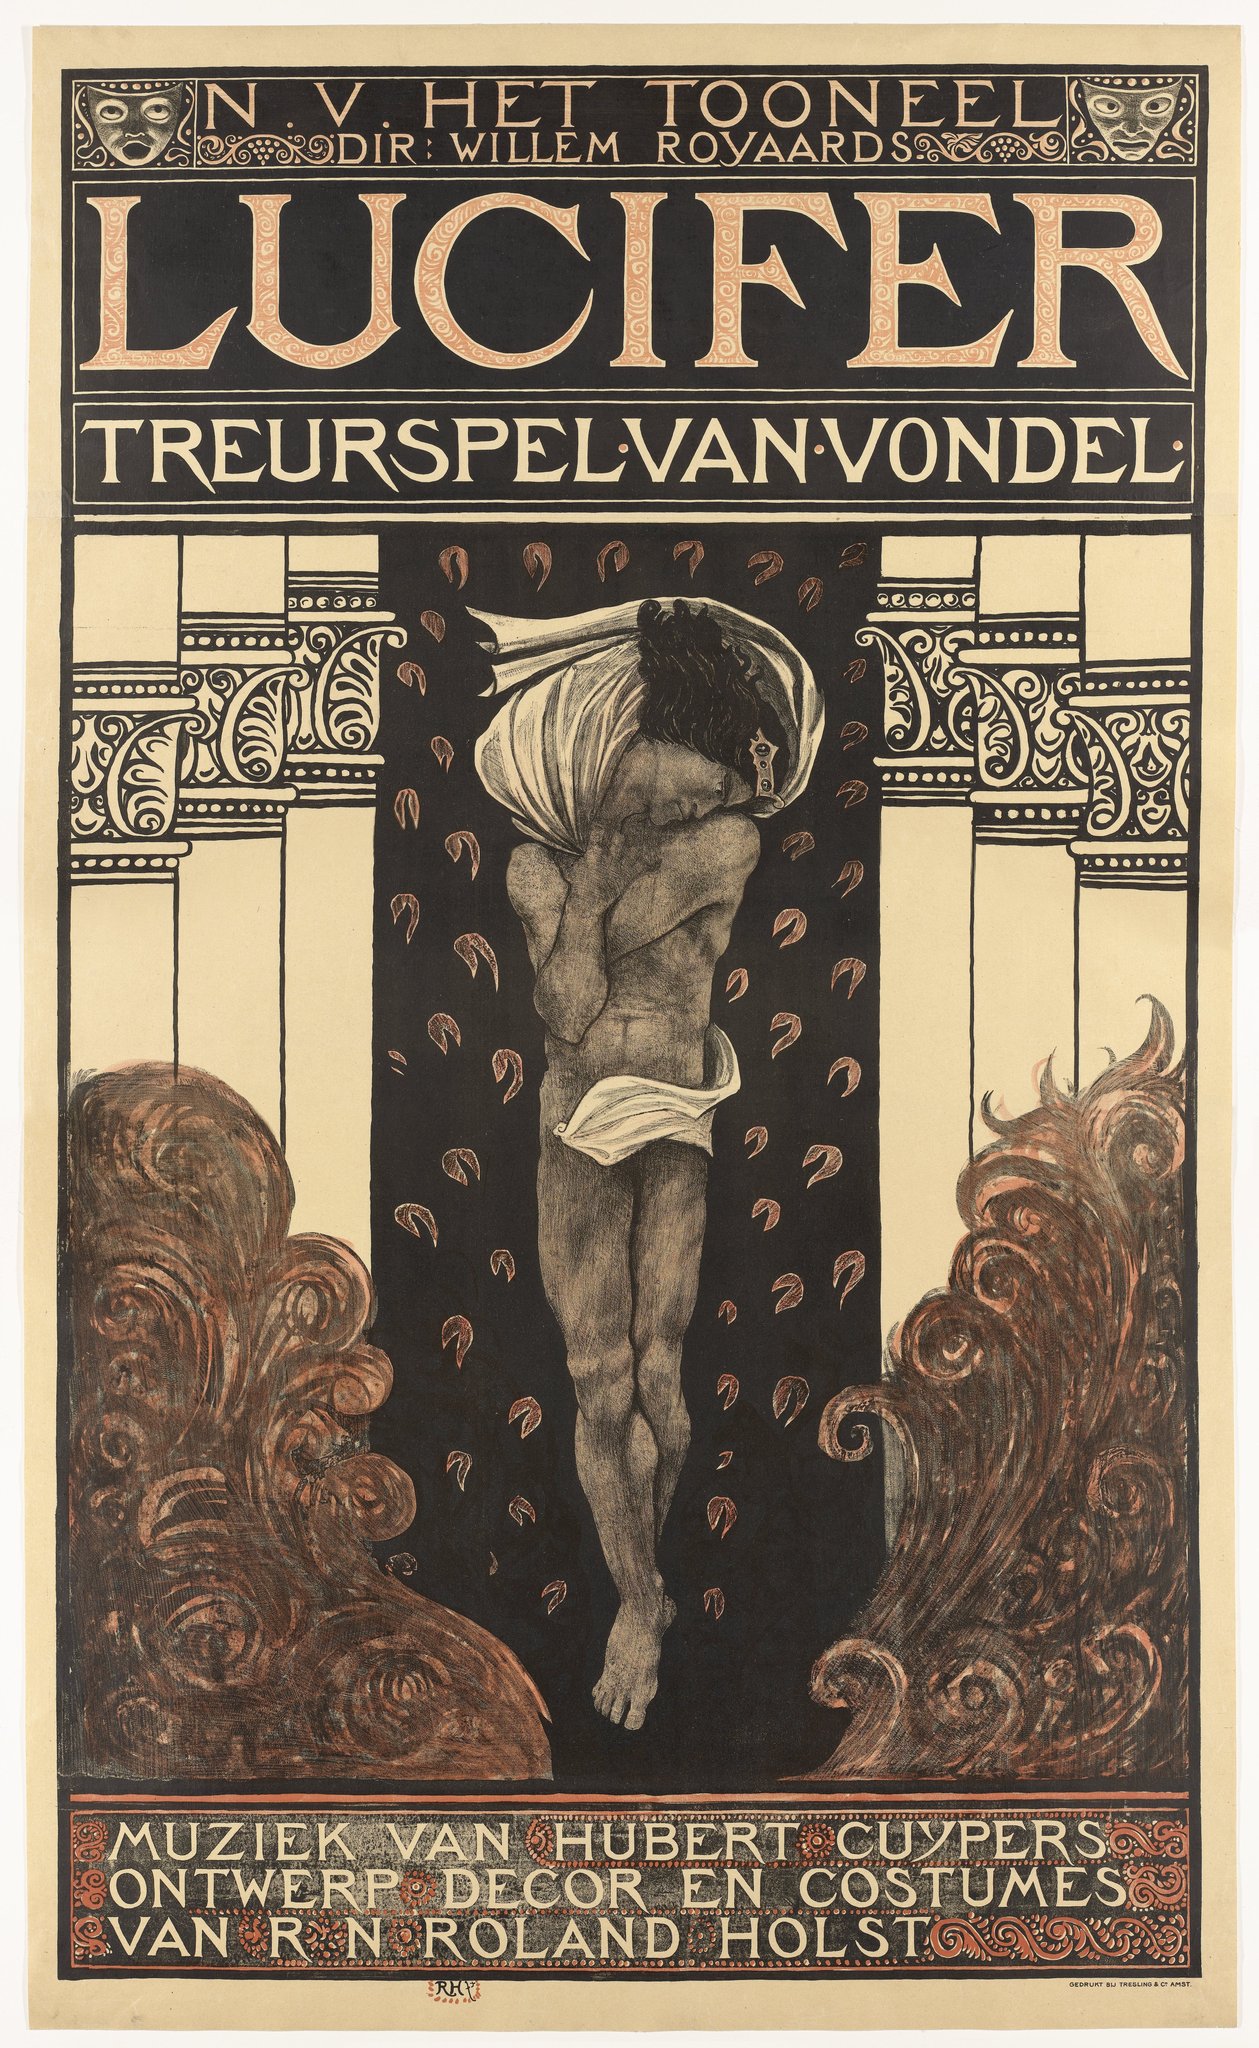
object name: poster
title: N.V. Het Toneel. Dir. Willem Royaards. Lucifer treurspel van Vondel. Muziek van Hubert Cuyper. Ontwerp, decor, costuums van R.N. Roland Holst.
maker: richard nicolaüs roland holst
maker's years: 1868-1938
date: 1910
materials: paper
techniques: lithograph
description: Affiche voor toneelstuk Lucifer van Vondel.